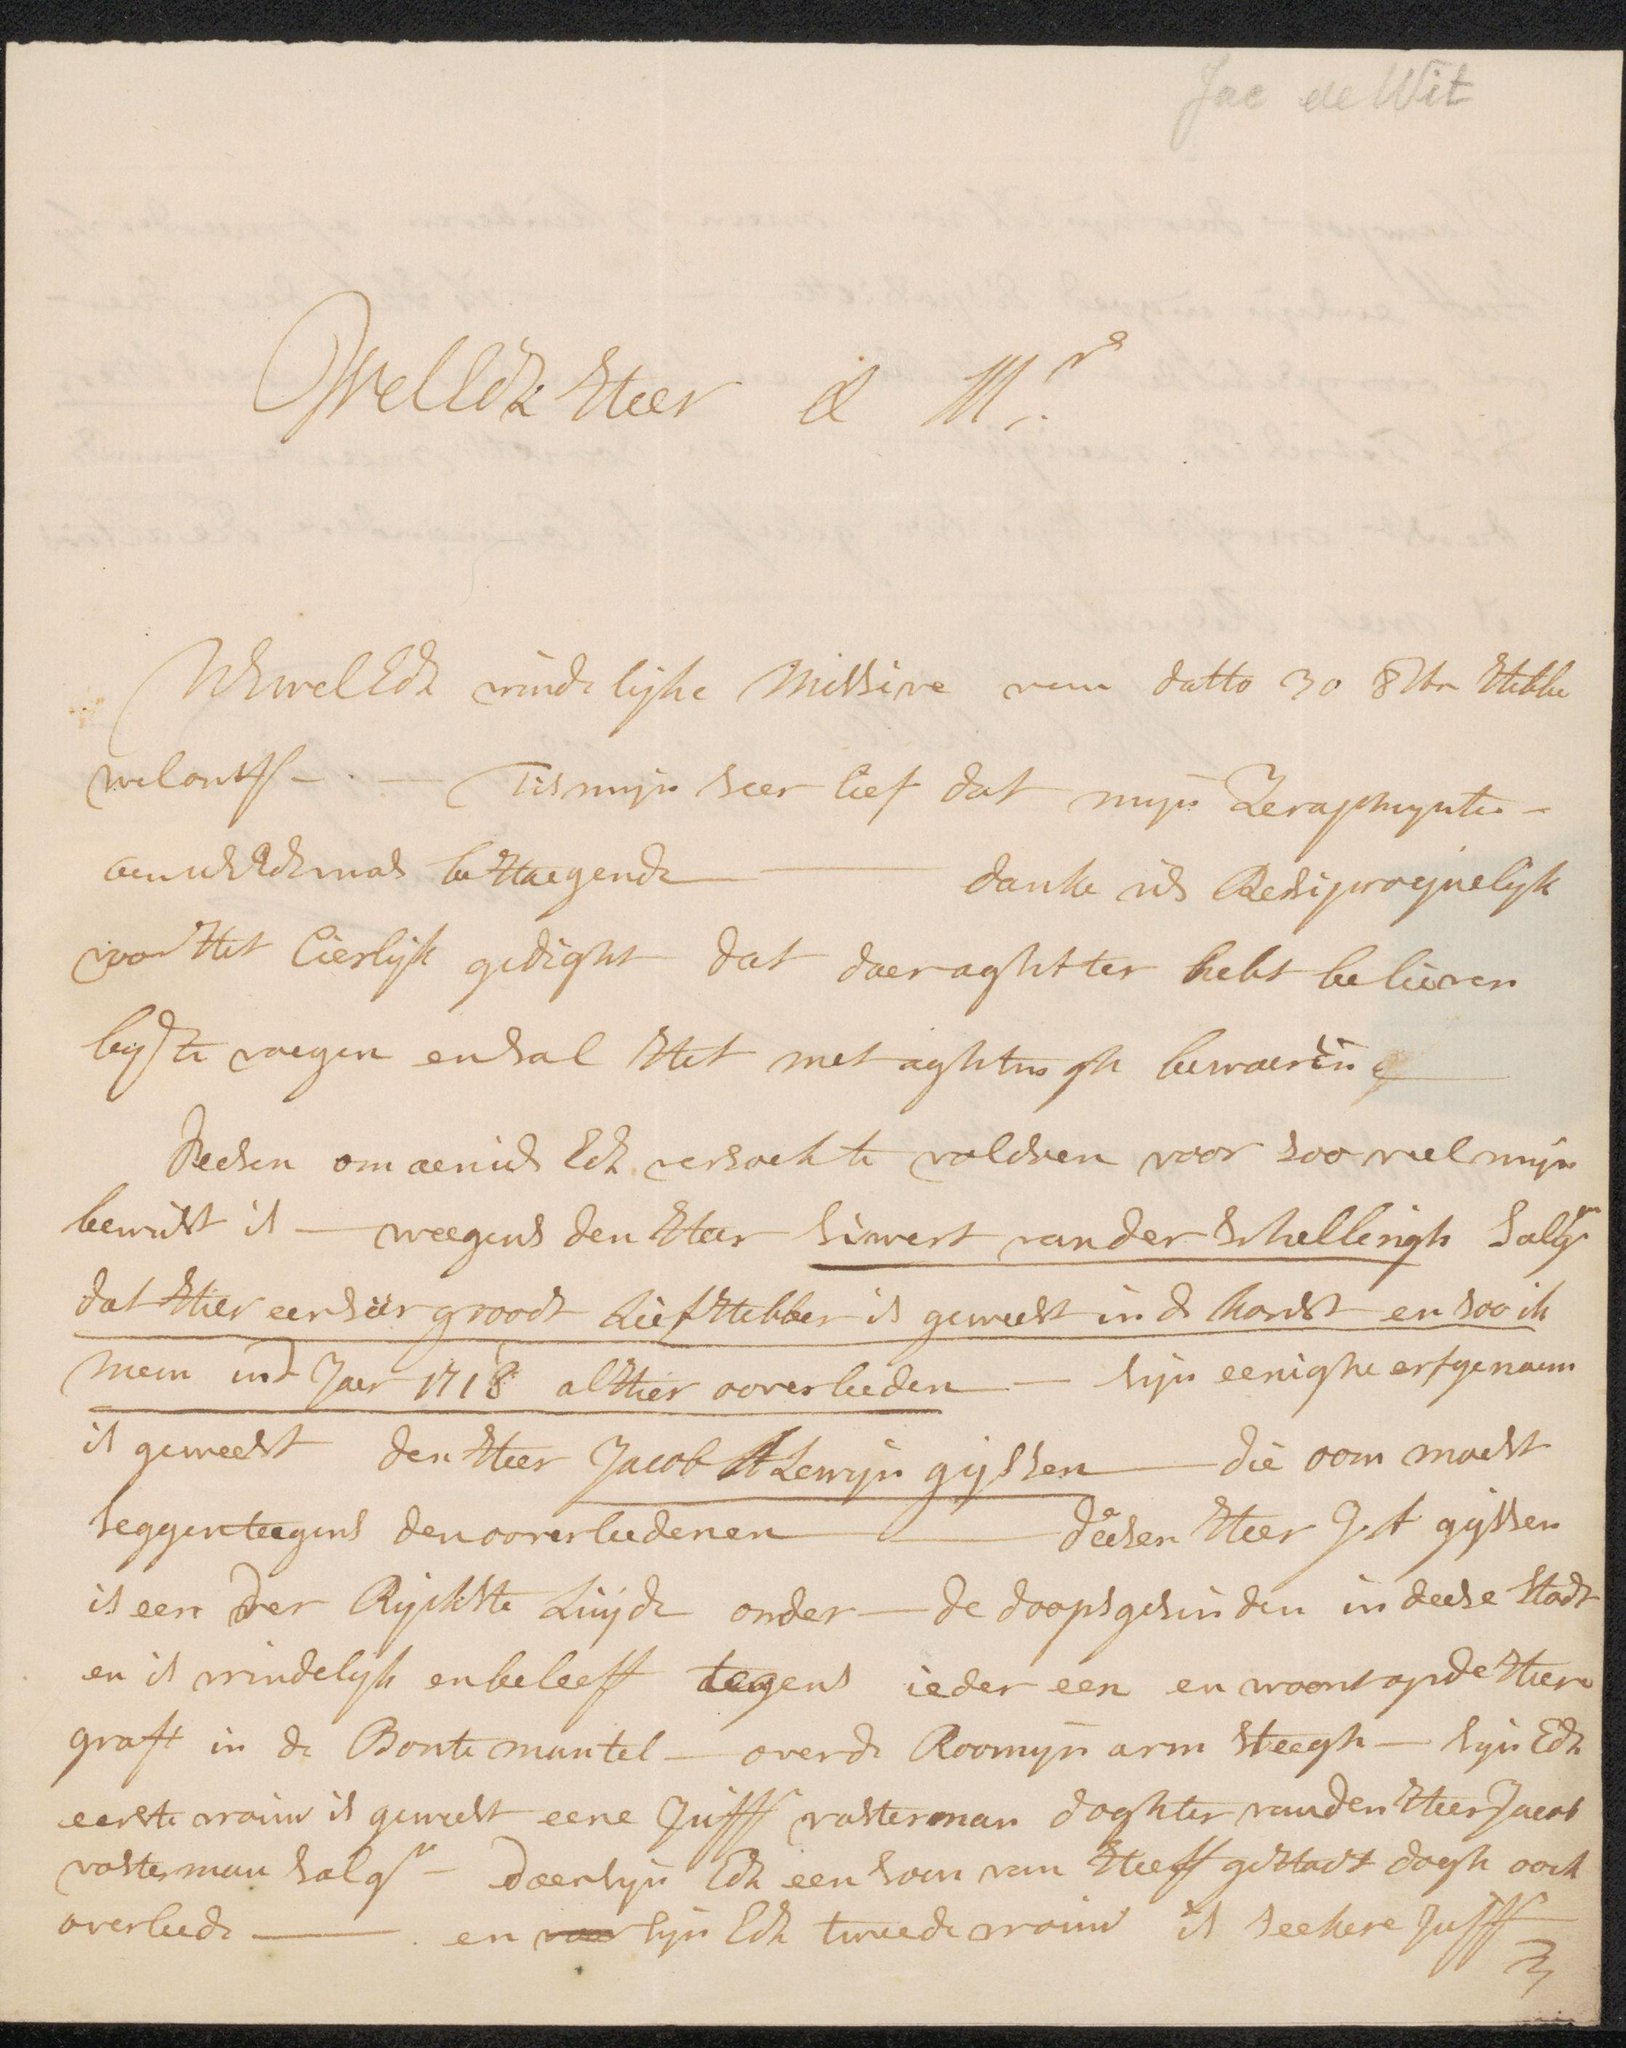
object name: letter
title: Brief aan de heer en mevrouw Pieter van der Schellingh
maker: jacob de wit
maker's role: draughtsman, painter, print maker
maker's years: 1695-1754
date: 1743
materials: ink, paper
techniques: pen, writing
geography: amsterdam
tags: literature ~ arts, art collecting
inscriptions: watermark, collector's mark: Lugt 2228